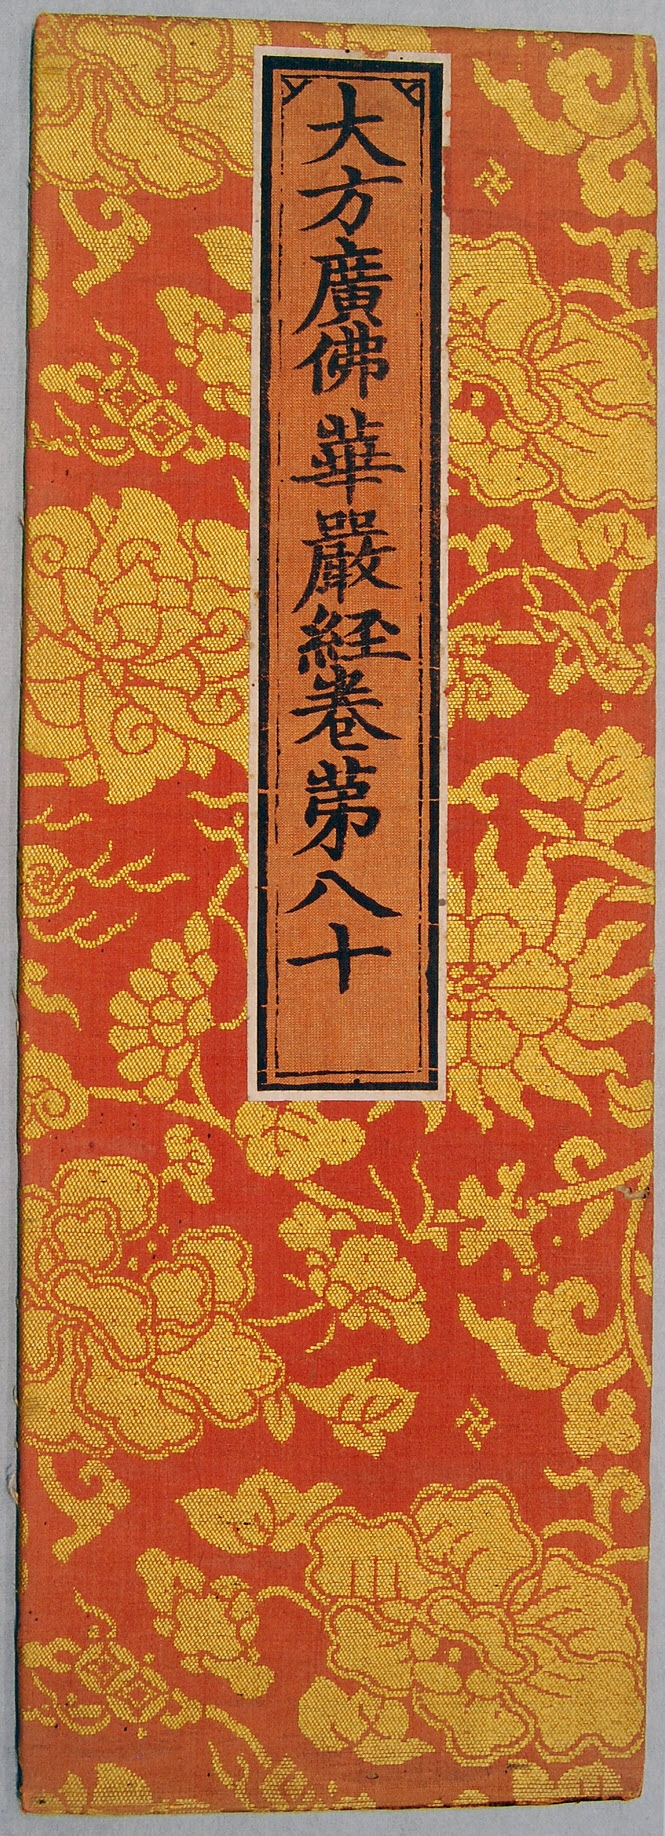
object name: sutra cover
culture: chinese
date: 1501-1600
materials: silk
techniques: patterning, weave